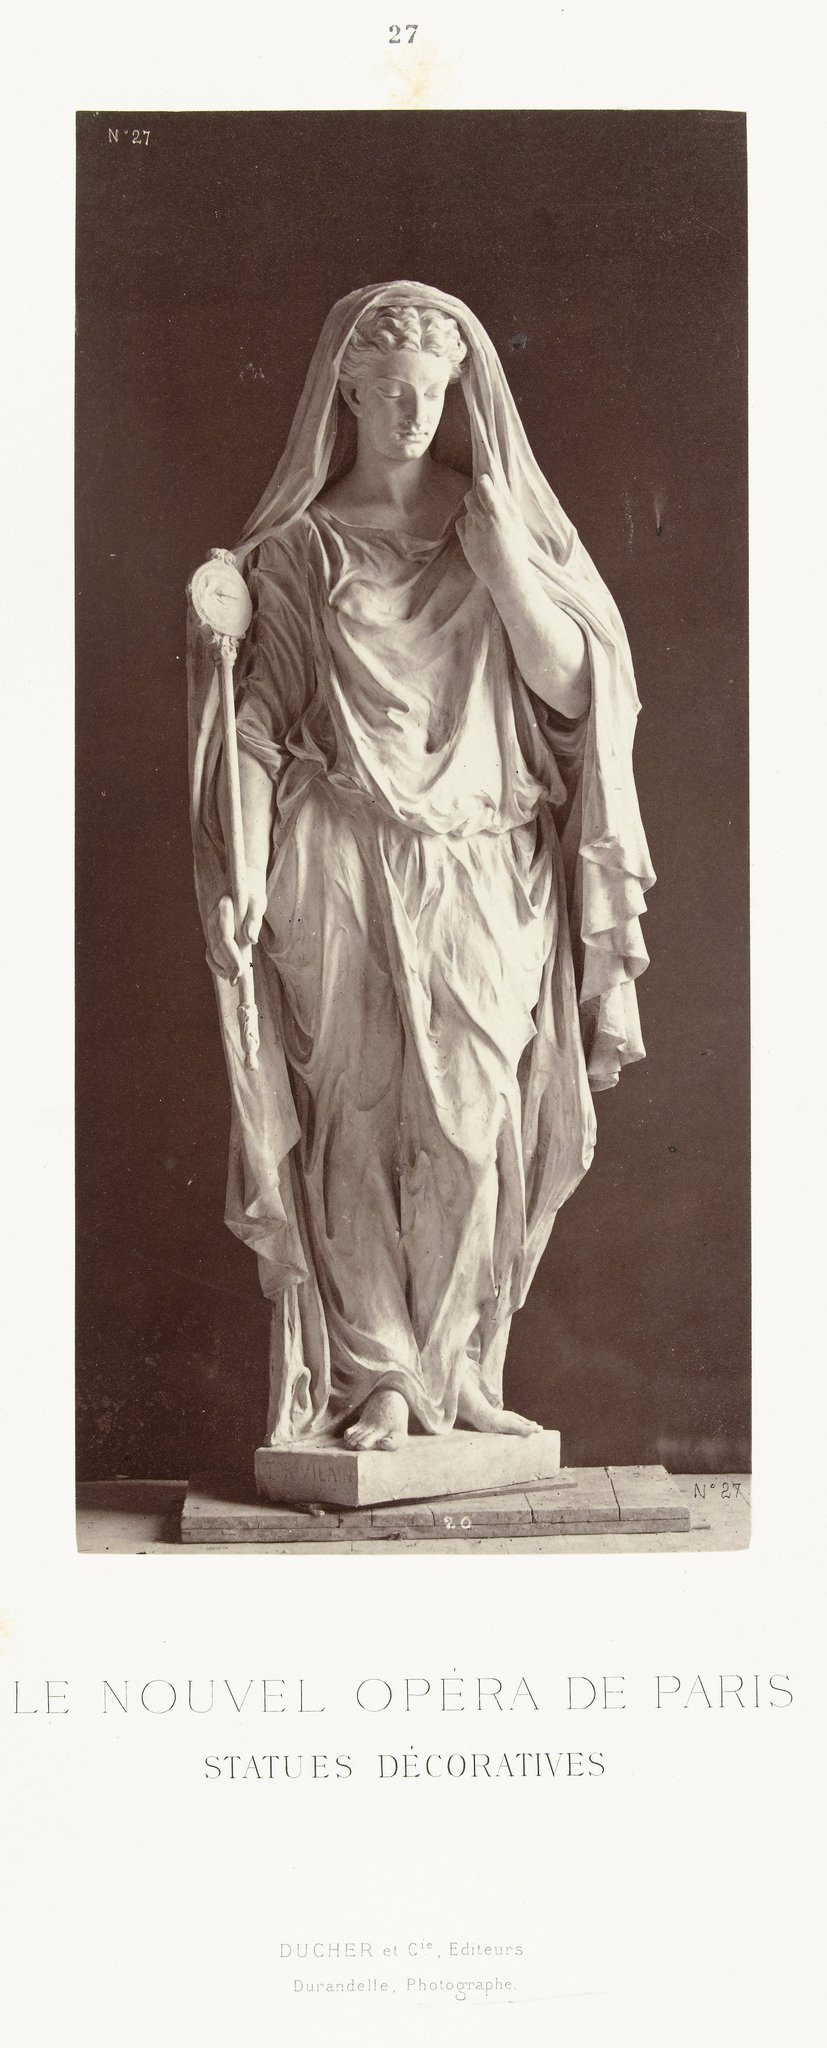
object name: photograph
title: Marmeren beeld van een gesluierde vrouw in een hooggesloten jurk met een staf in haar rechterhand.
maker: louis-emile durandelle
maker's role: fotograaf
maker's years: 1839-1917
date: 1878-1881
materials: photographic support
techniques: albumen print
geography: paris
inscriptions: number: ‘27’, number: ‘20’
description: bij boek in Bibliotheek RMA, Zie Frizot, pp. 217-223, vgl G. Vicaire, Manuel de l'amateur de livres du XIXe siècle, vol. 3, column 870.